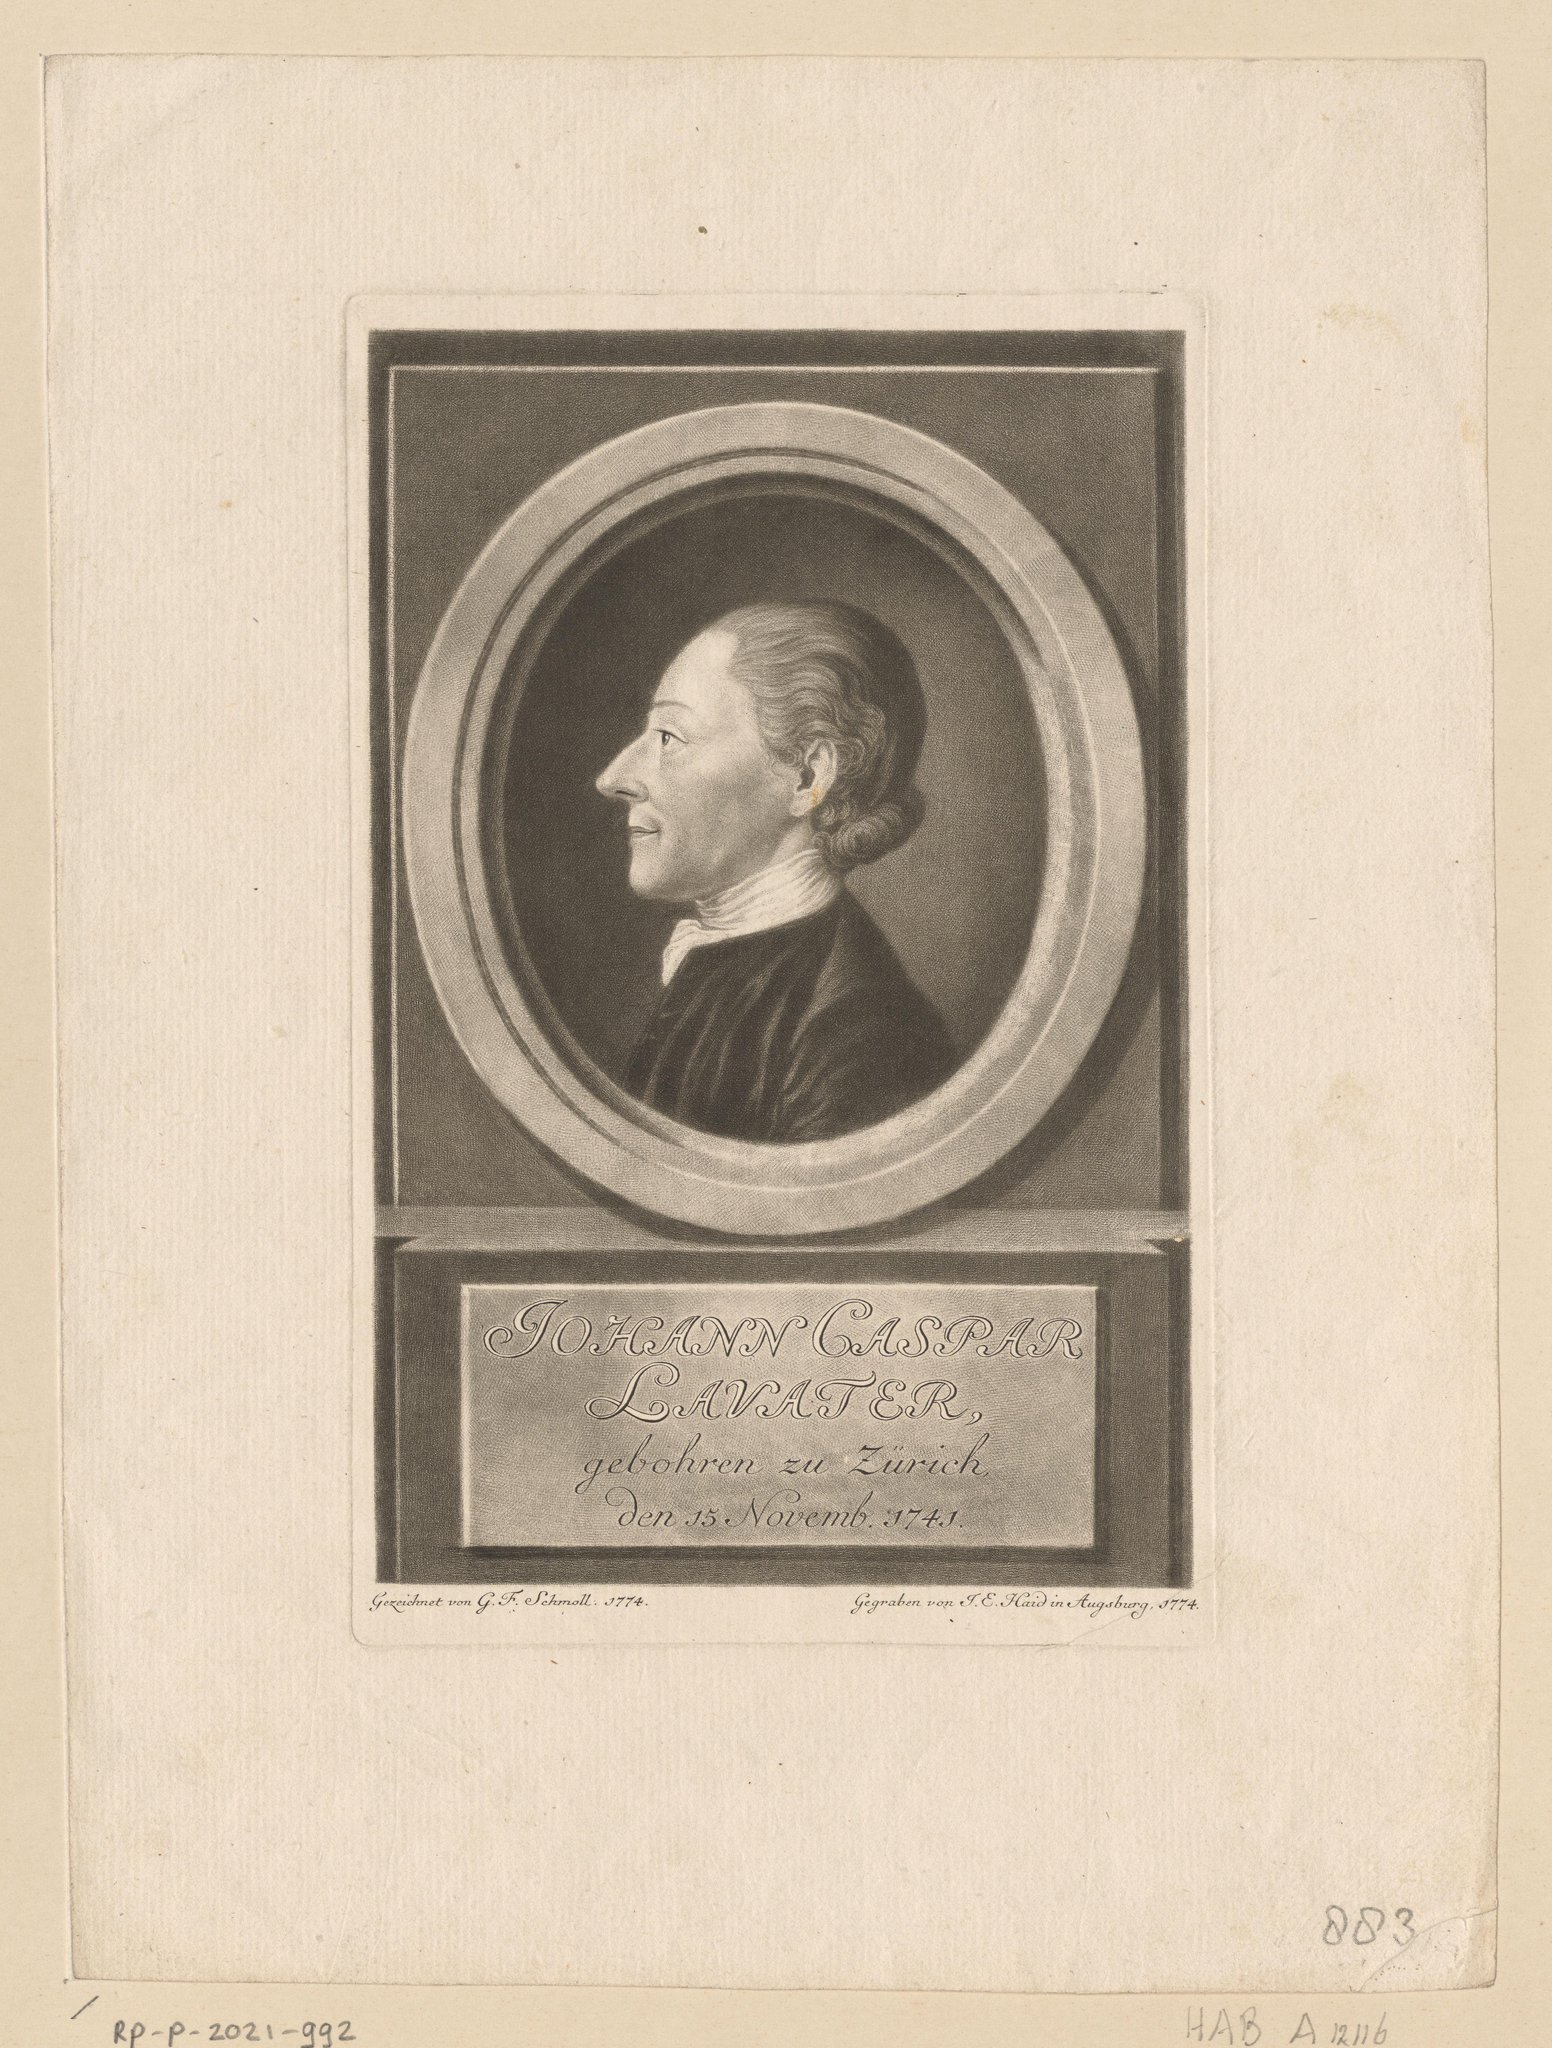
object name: print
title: Portret van Johann Caspar Lavater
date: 1774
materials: paper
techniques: etching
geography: augsburg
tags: johann caspar lavater, ornament ~ medallion, historical persons, scholar, philosopher (+ portrait of scholar, scientist)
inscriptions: date